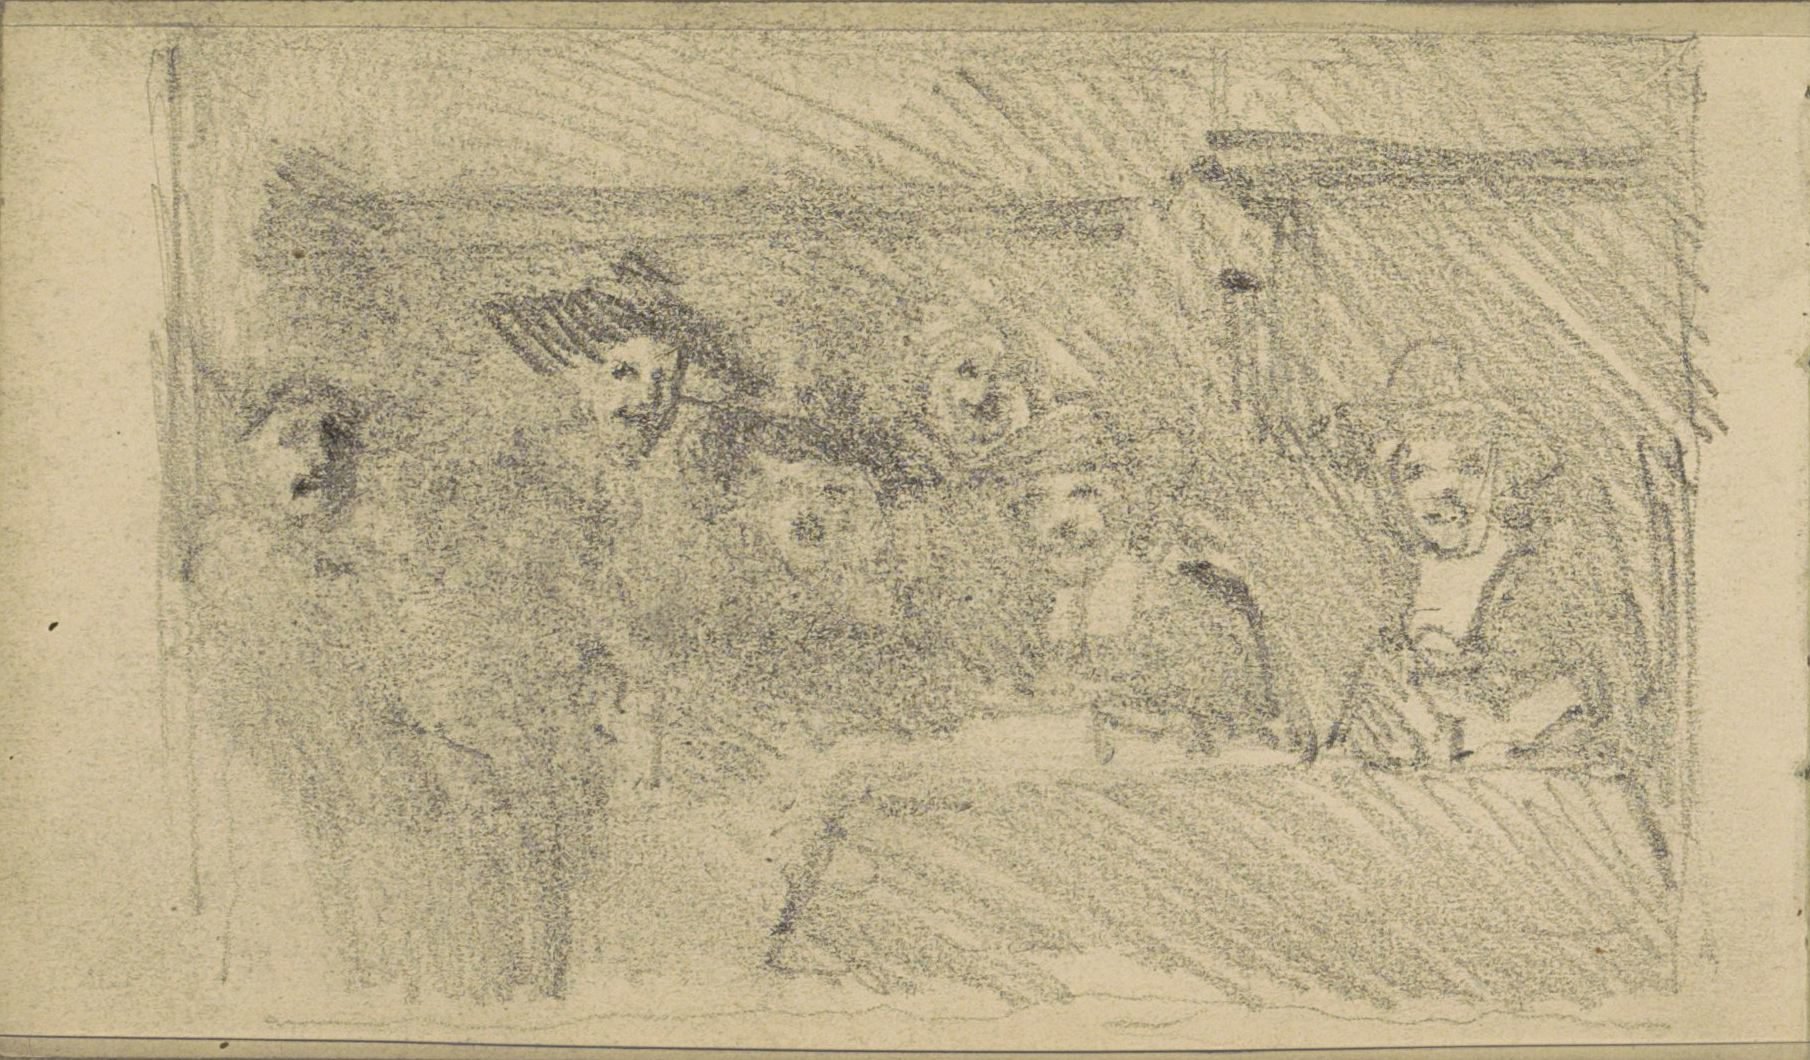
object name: sketchbook leaf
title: Kopie naar 'De Staalmeesters' van Rembrandt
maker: george clausen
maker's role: draughtsman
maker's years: 1852-1912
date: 1875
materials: paper, pencil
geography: amsterdam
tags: picture, painting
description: Blad 38 verso uit een schetsboek met 46 bladen.